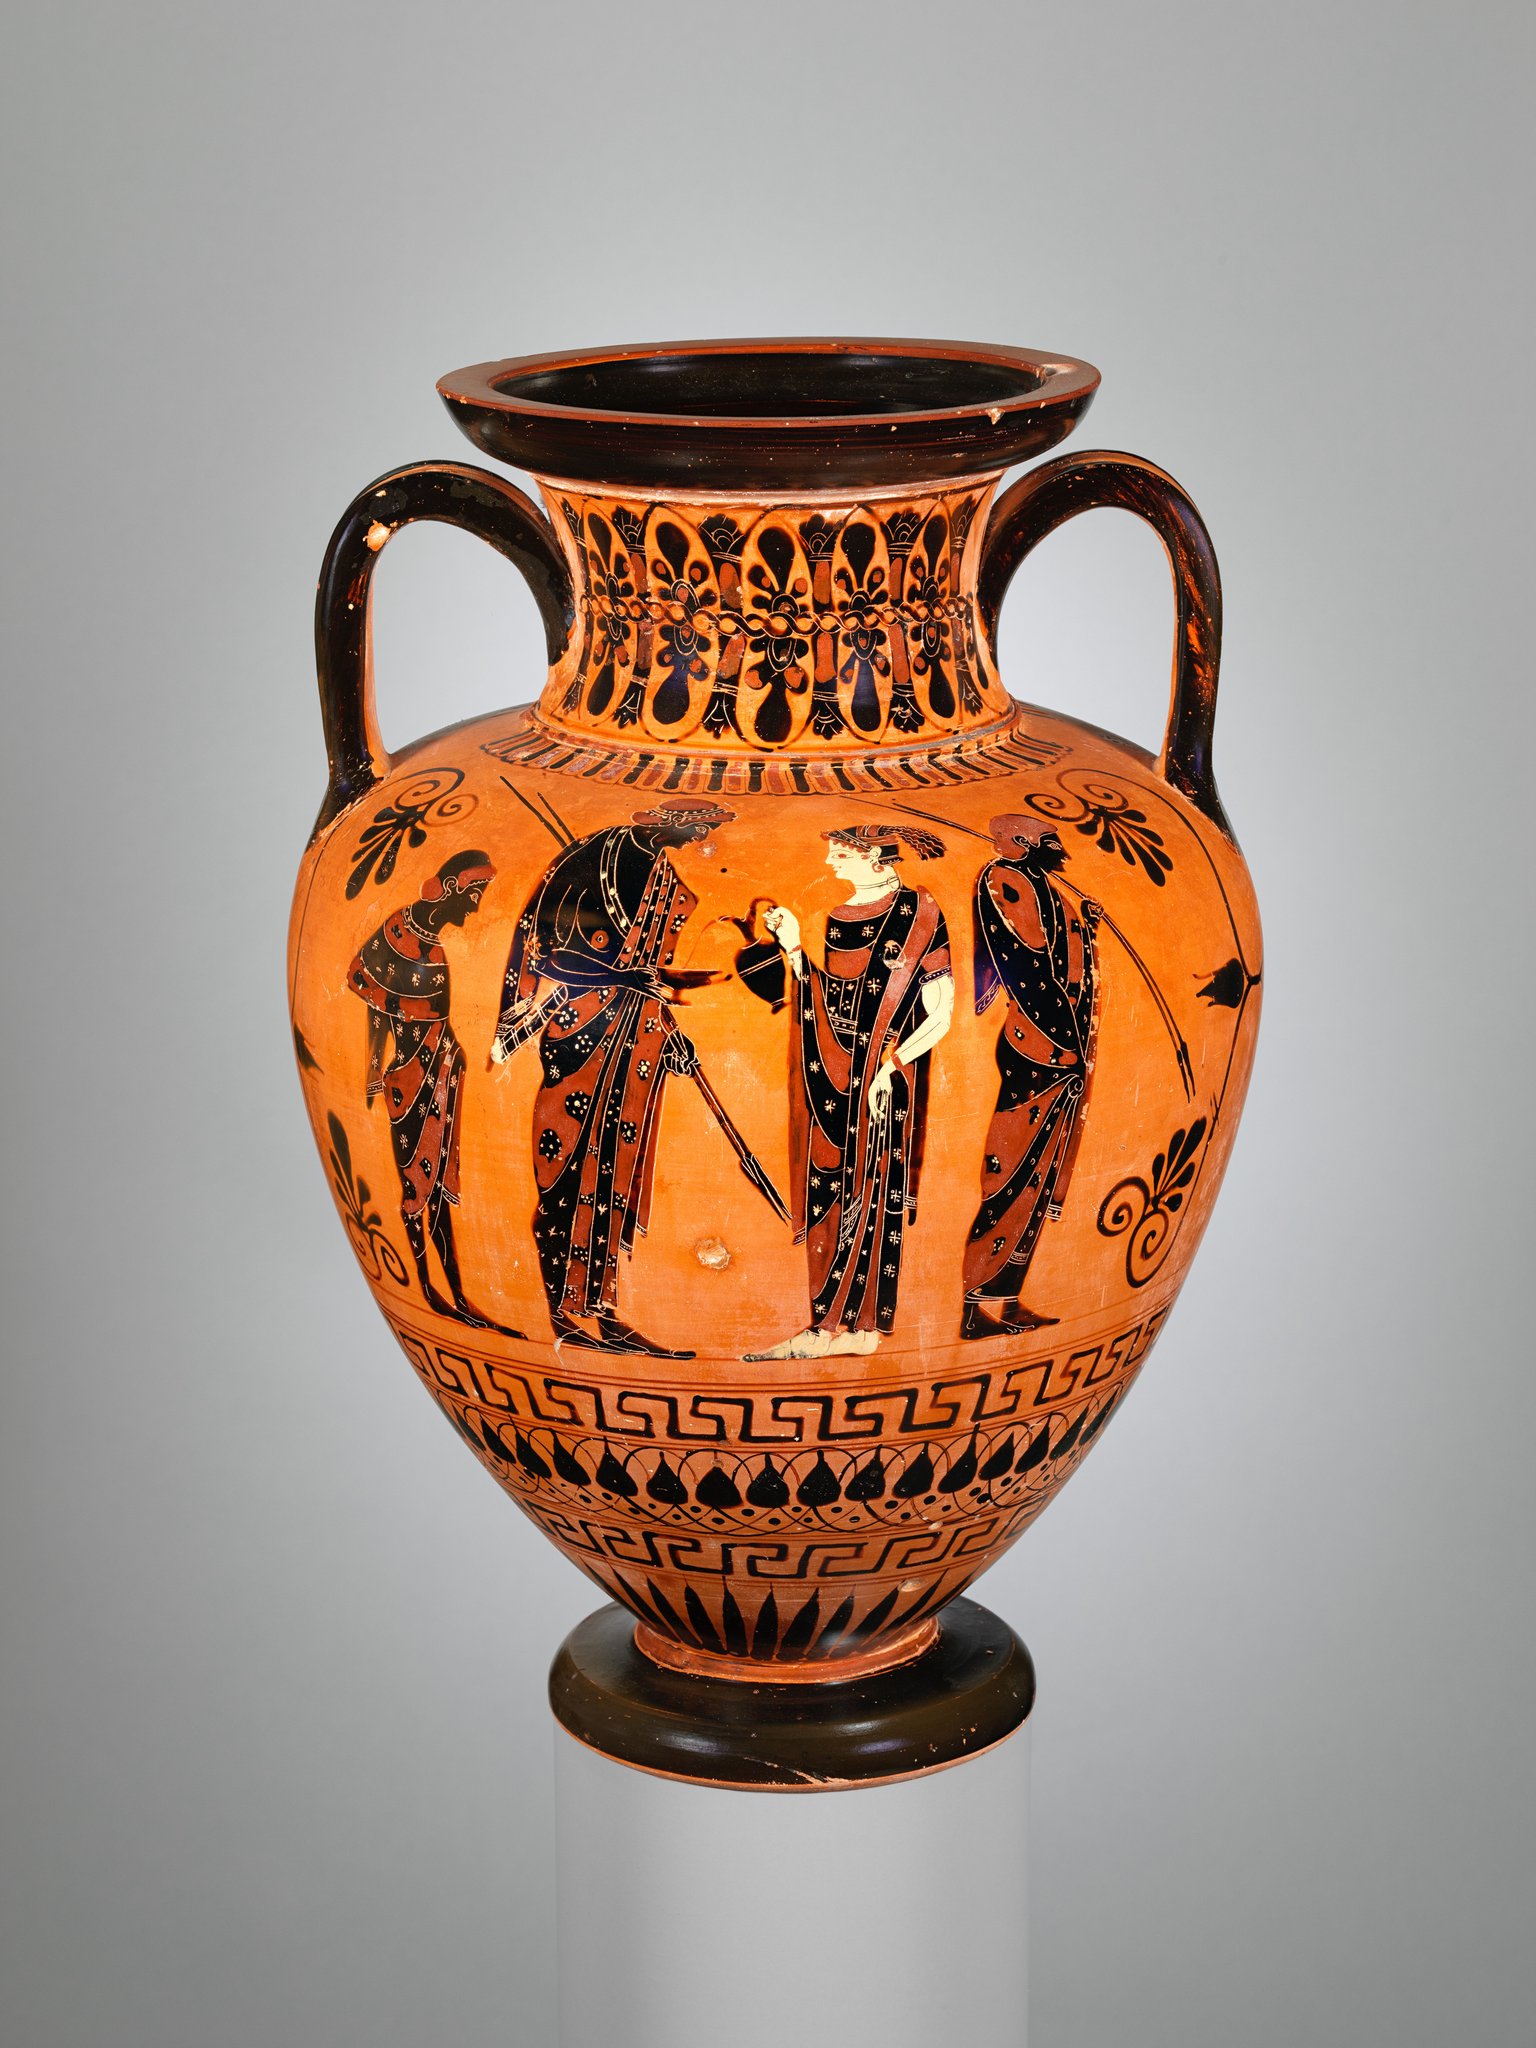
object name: neck amphora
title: Terracotta neck-amphora (jar)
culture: greek, attic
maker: painter of munich 1410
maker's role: artist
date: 530 BCE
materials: terracotta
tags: spears,swords,men,women